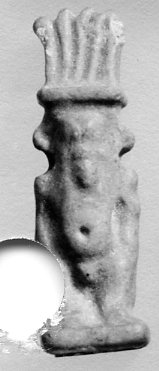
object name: amulet, be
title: Bes amulet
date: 664-332 BCE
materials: faience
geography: egypt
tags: bes